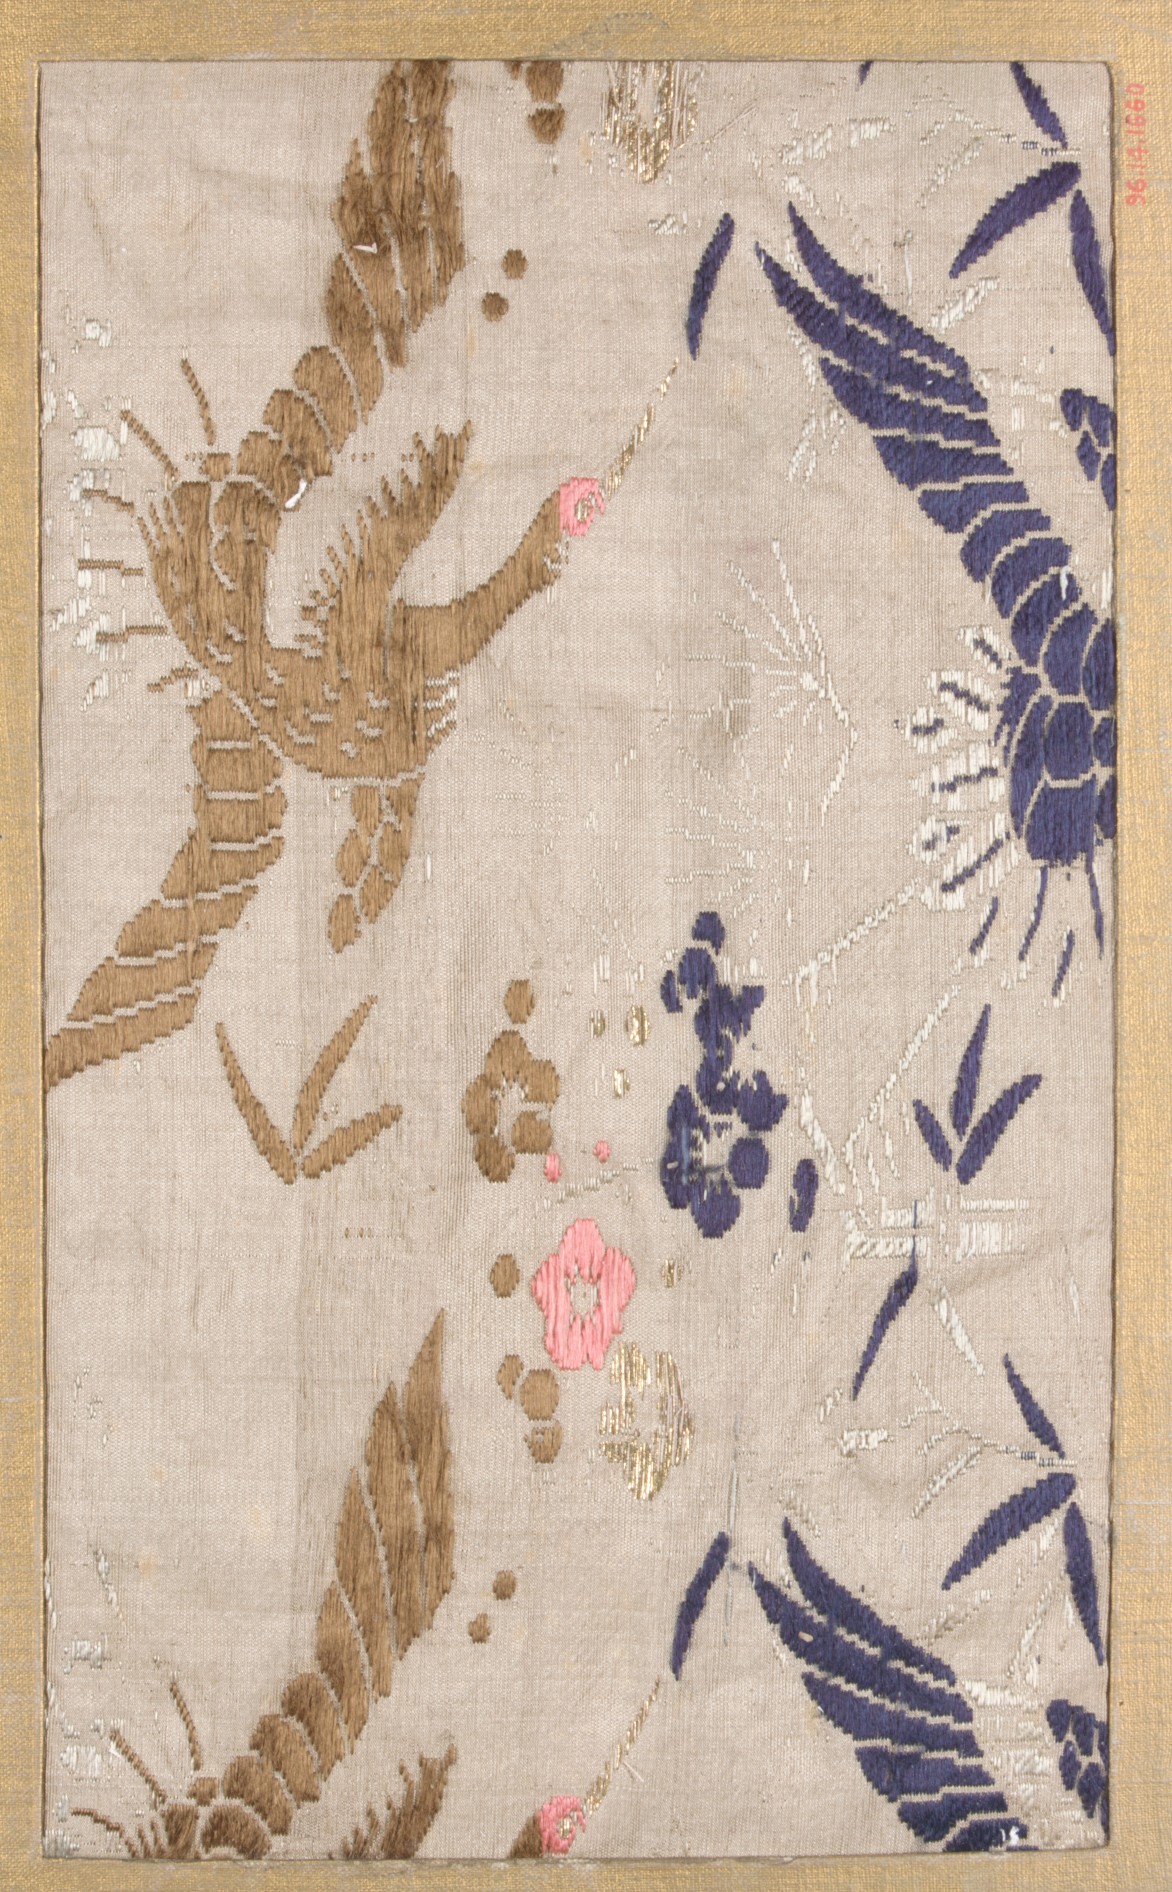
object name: piece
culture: japanese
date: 1701-1900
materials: silk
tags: birds